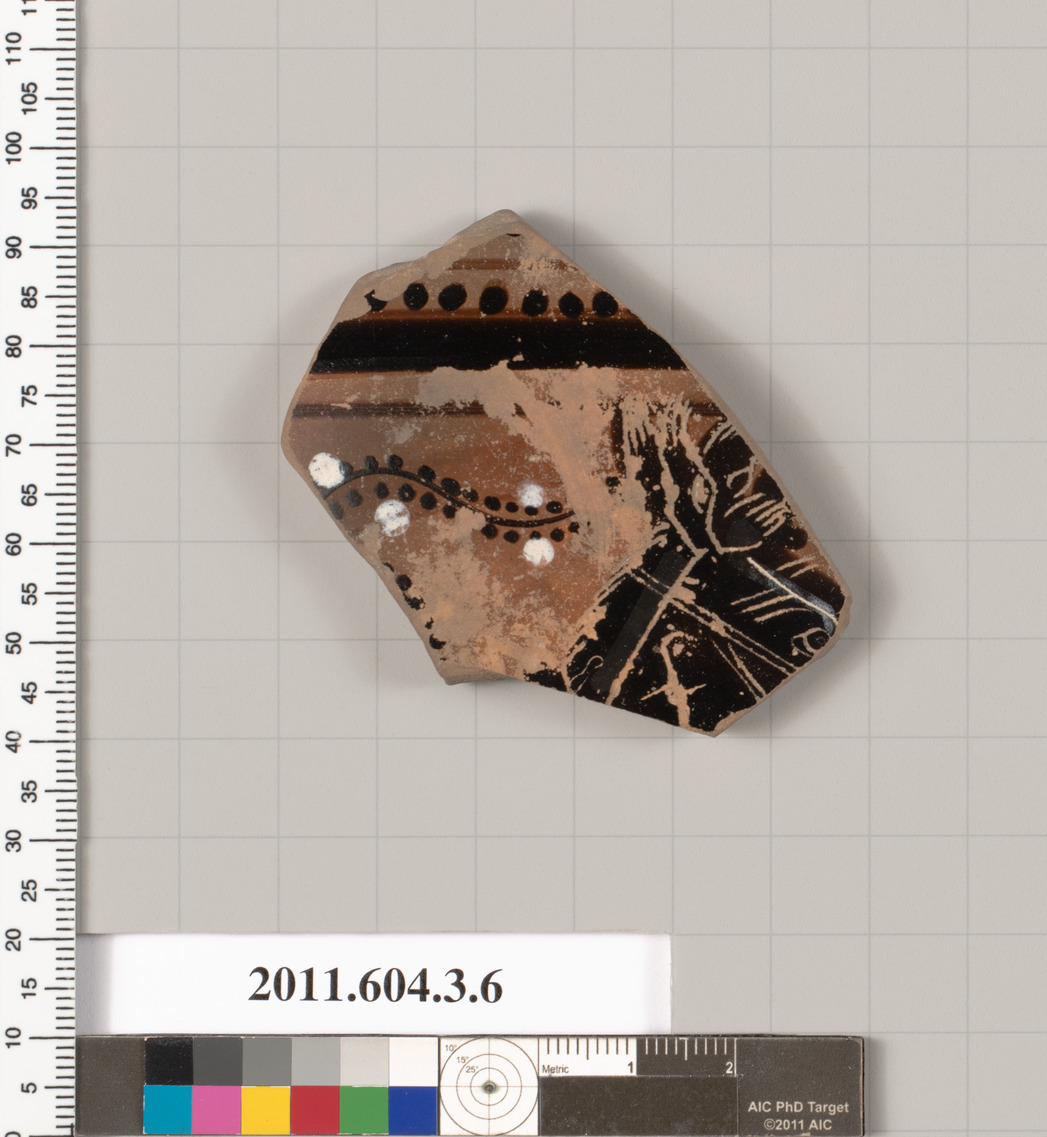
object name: skyphos fragment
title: Terracotta fragment of a skyphos (deep drinking cup)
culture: greek, attic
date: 490 BCE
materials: terracotta